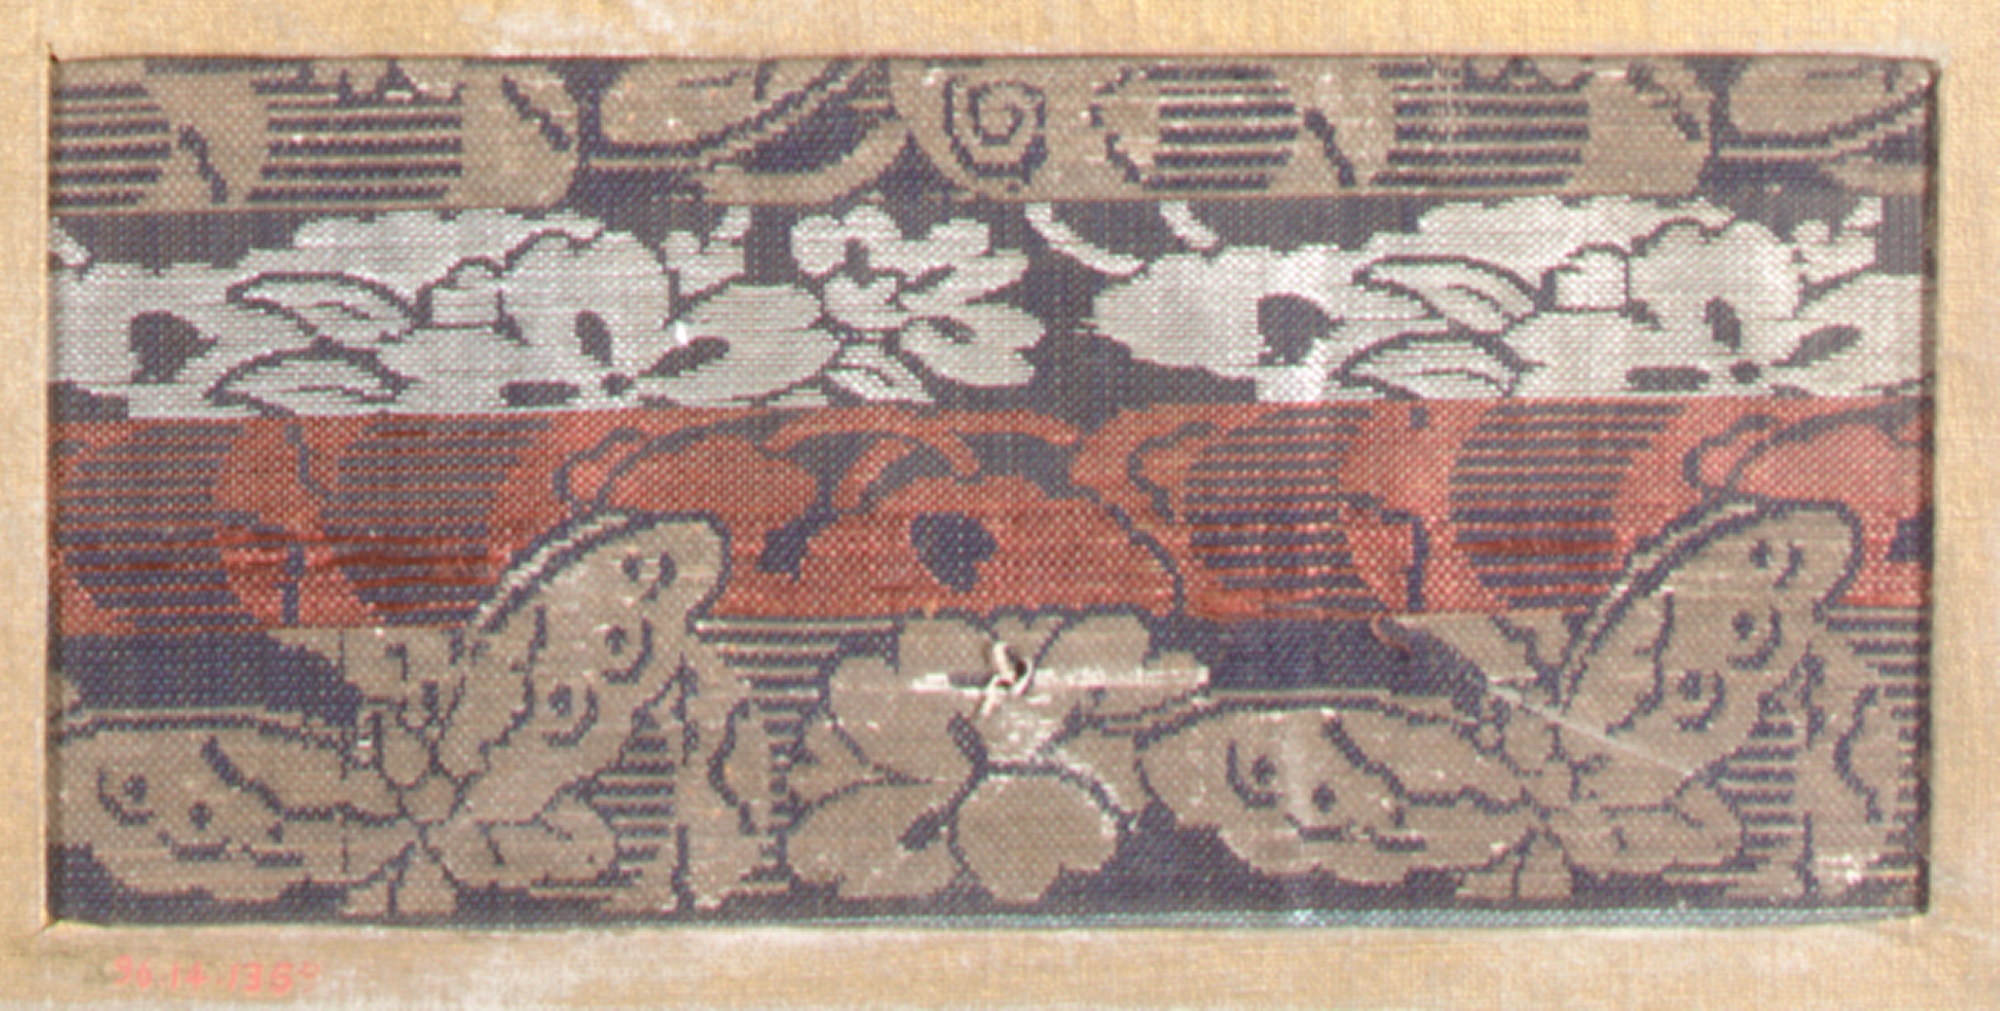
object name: piece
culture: japanese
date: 1701-1900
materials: silk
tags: flowers